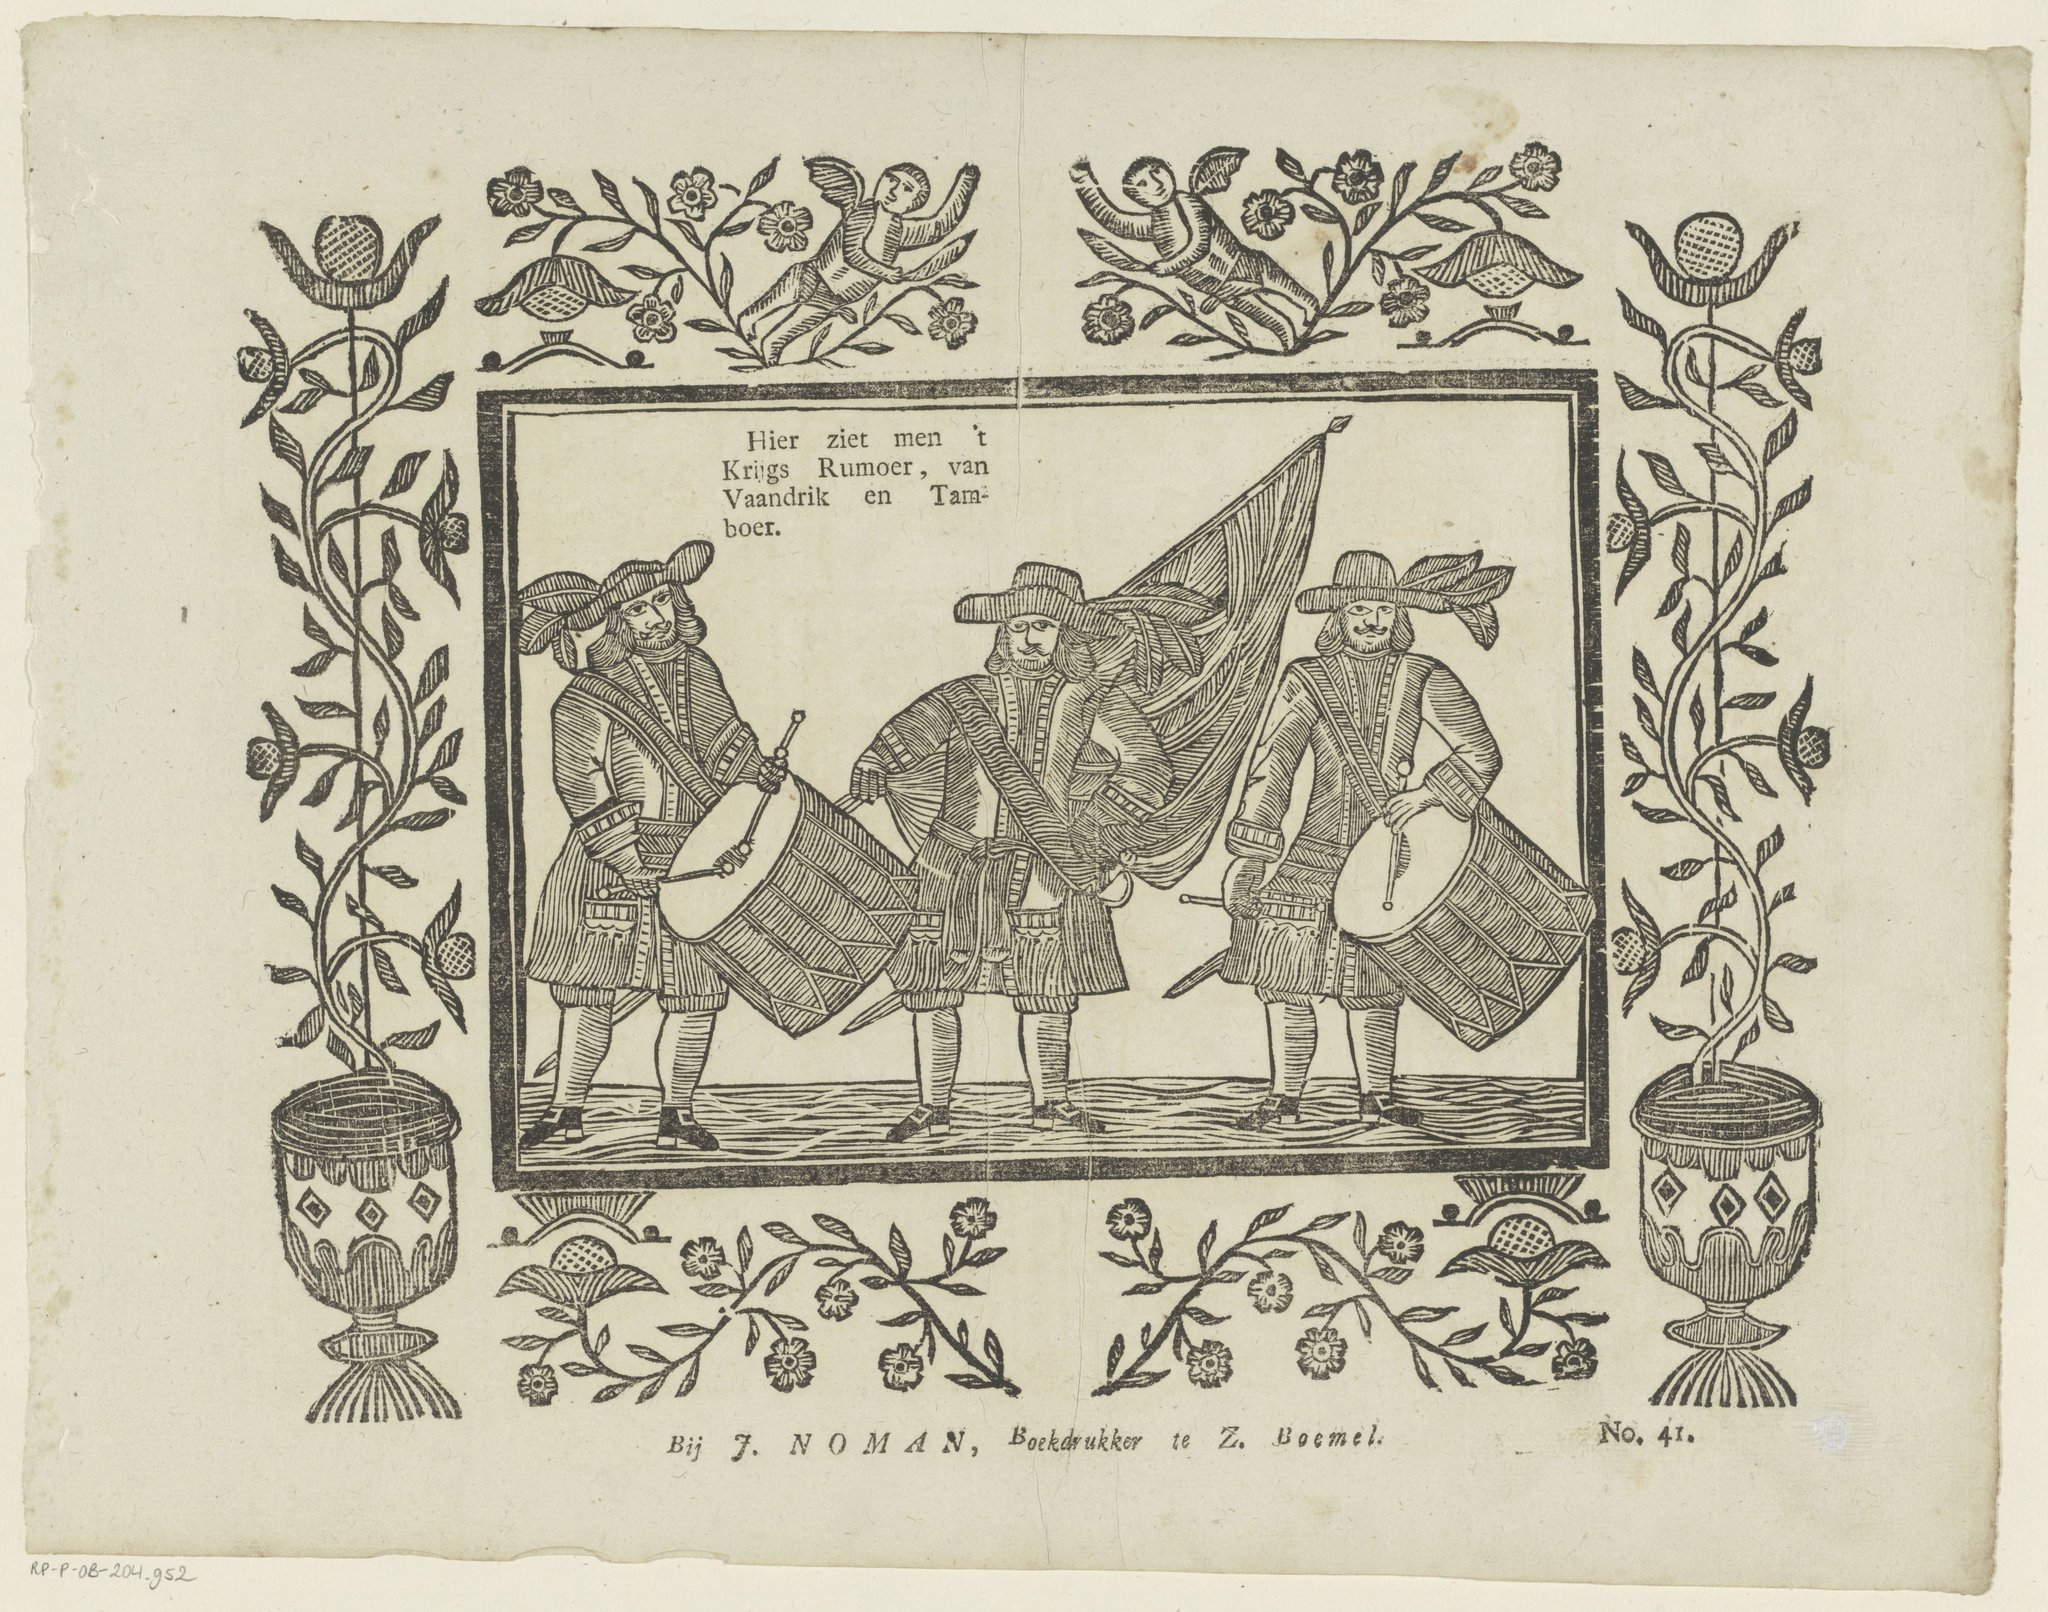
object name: print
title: Hier ziet men 't / Krijgs rumoer, van / Vaandrik en tamboer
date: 1806-1830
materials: paper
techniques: letterpress printing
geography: netherlands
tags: military music, standard-bearer, flag-bearer, (military) standard-bearer, drum (musical instrument)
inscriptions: collector's mark: Lugt 2760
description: Blad met een grote voorstelling van een vaandeldrager en twee tamboers. De voorstelling is gevat in een sierlijst van bloemenranken, vazen en putti. Genummerd rechtsonder: No. 41.